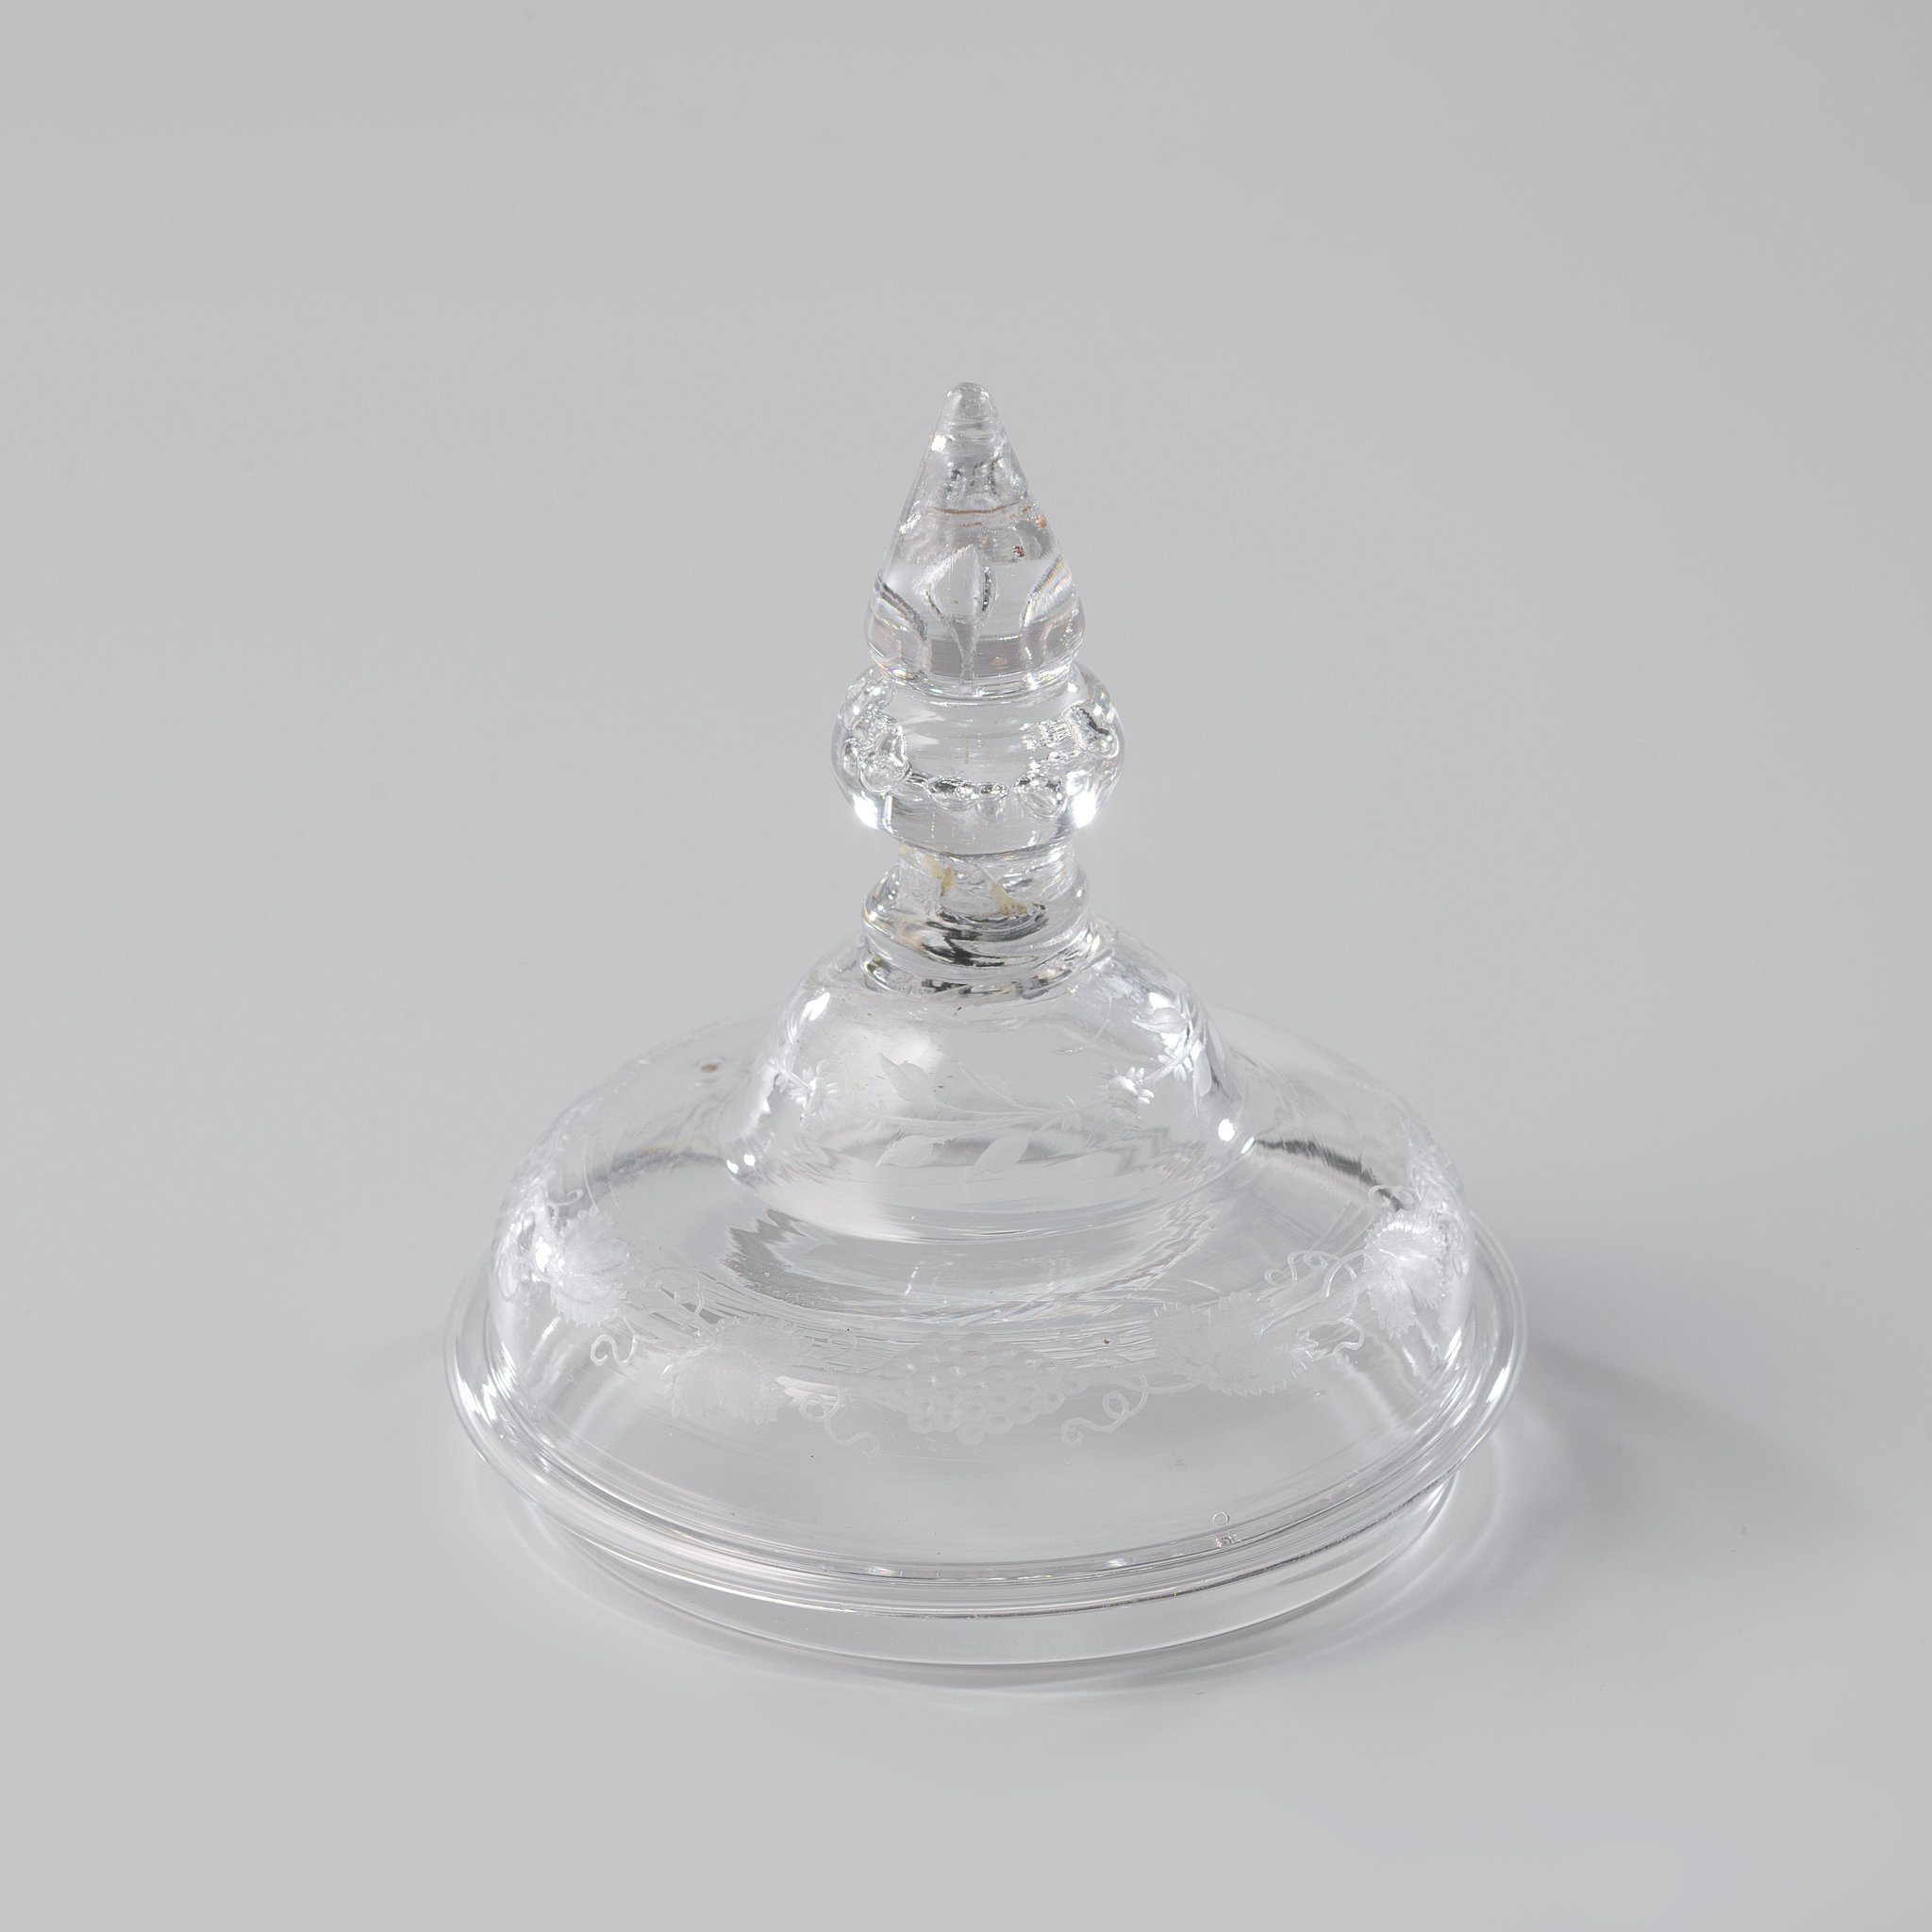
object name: lid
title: Deksel van een bokaal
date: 1699-1799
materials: glass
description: Deksel van een bokaal met een uitgebogen voetrand en een dubbelle welving. De dubbele knop bestaat uit een kogel en een conische spits. Graveerwerk met wijnranken, wijnbladeren en druiventrossen op de eerste welving en een bloemmotief met knoppen op de tweede. Hoort oorspronkelijk niet bij BK-NM-10987-A.